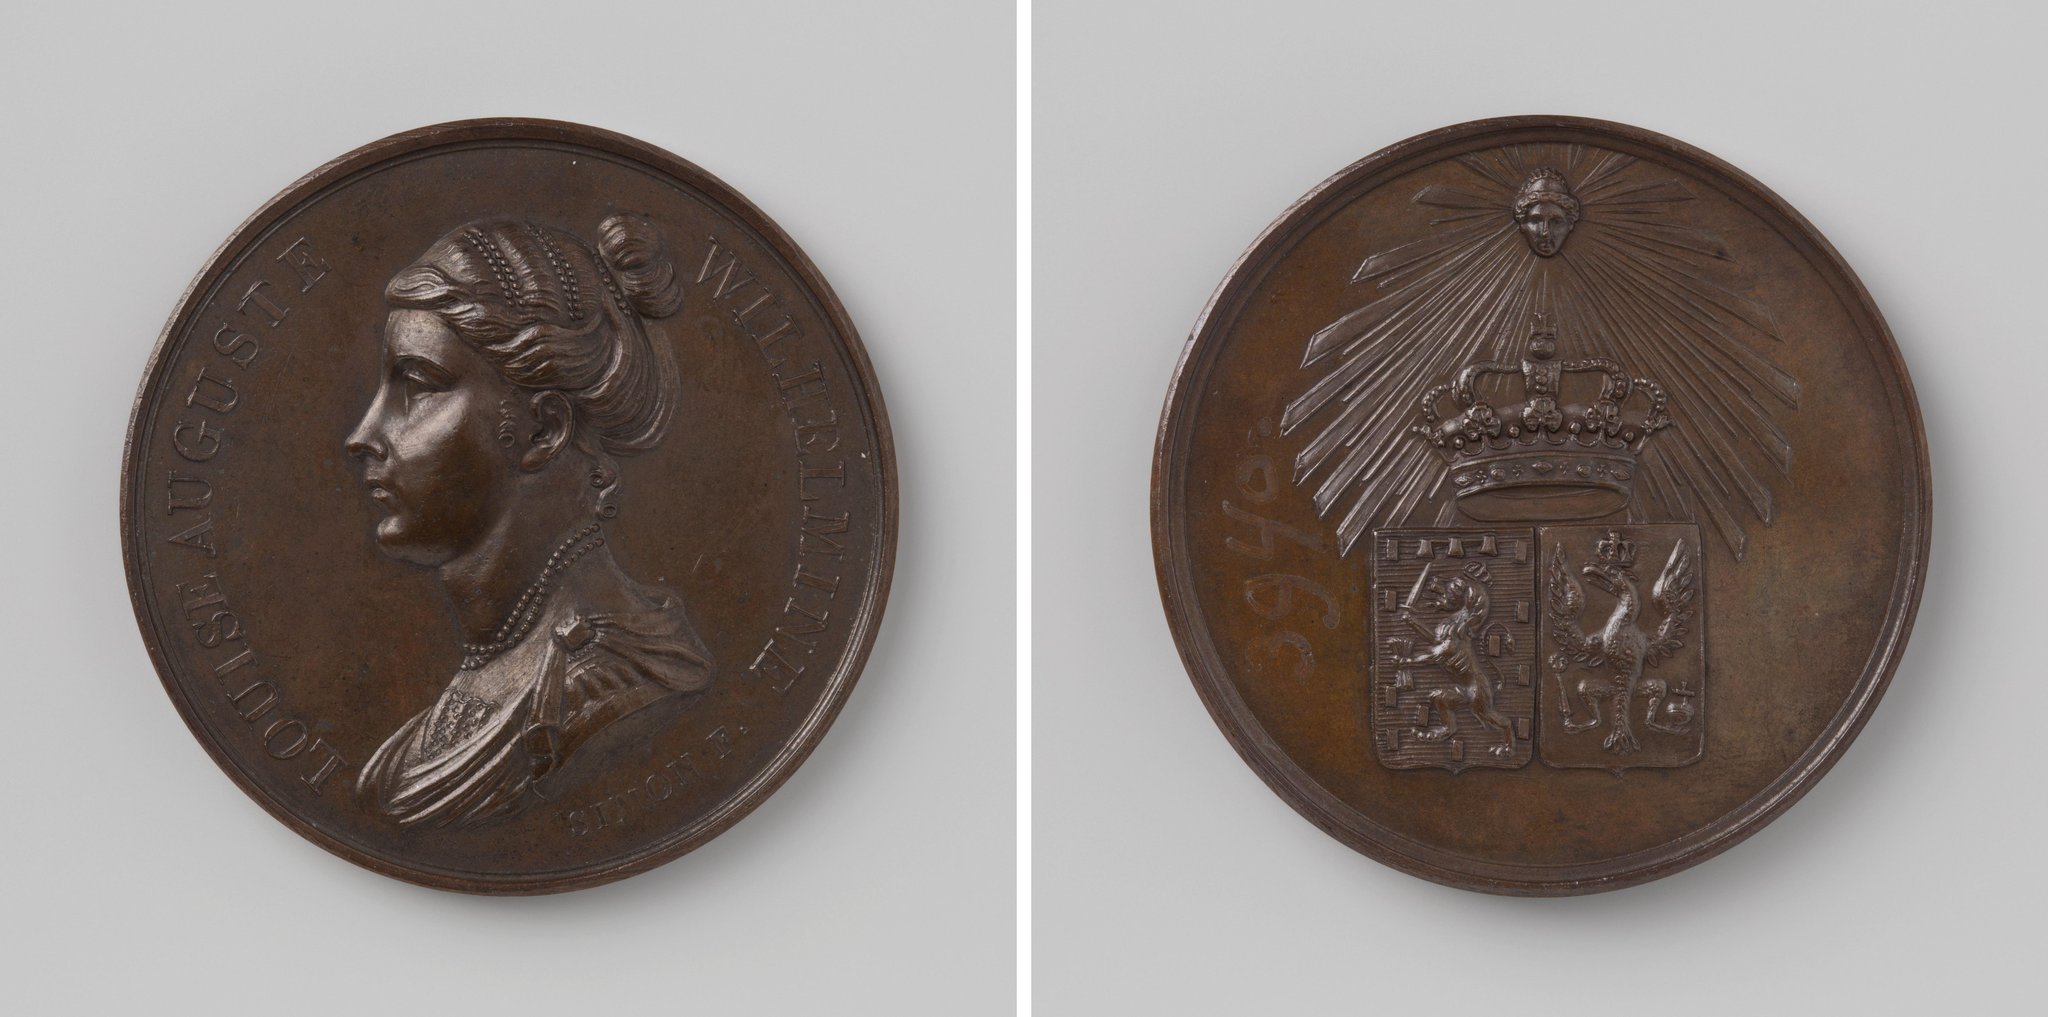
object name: history medal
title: Louise Augusta Wilhelmina Amalia, prinses van Pruisen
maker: jean henri simon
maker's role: medailleur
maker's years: 1752-1834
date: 1845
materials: bronze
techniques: striking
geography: brussels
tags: koningsbergen, wassenaar, prinses, louise van pruisen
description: Bronzen penning. Voorzijde: borststuk vrouw binnen omschrift. Keerzijde: twee wapenschilden onder kroon,beschenen door mensenhoofd in stralenkrans